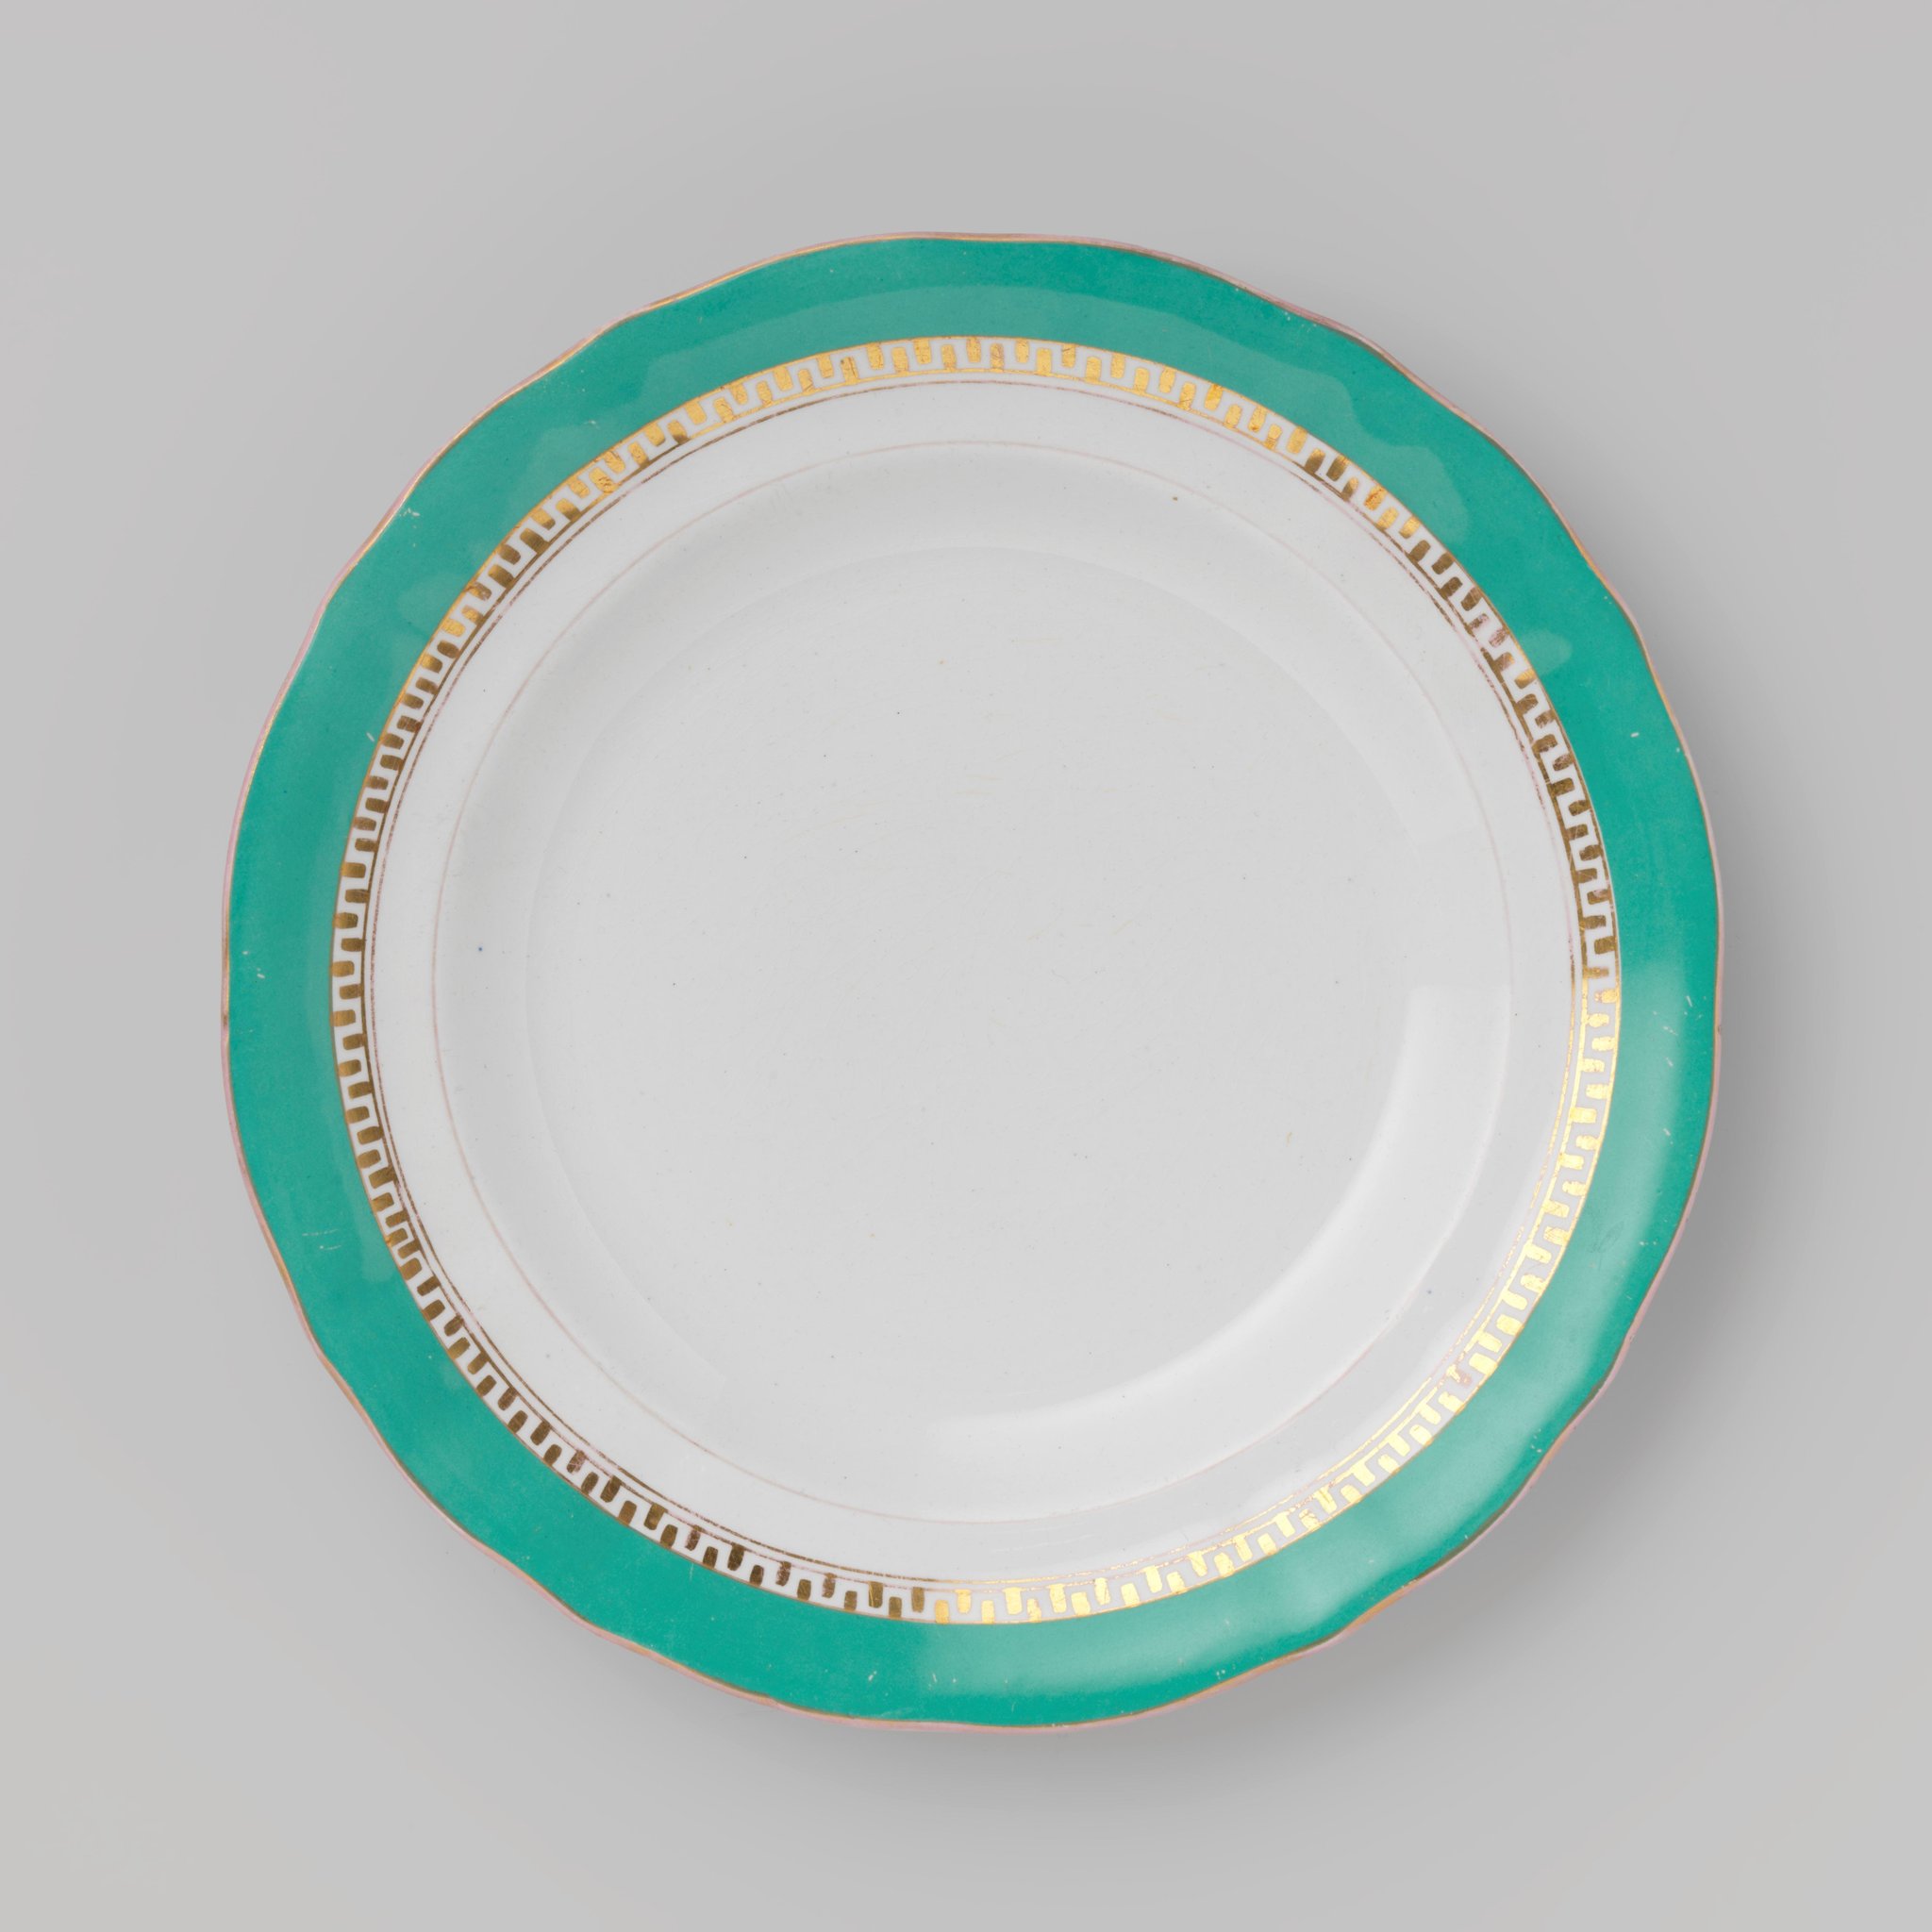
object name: plate dish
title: Bord met groene rand en gouden Griekse band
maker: petrus regout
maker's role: plateelbakker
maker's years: 1801-1879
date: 1865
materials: earthenware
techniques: transfer decoration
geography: maastricht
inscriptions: check stamp: ‘P. REGOUT // MAASTRICHT // 9X’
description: Bord van aardewerk, geschulpt, met groene rand en gouden Griekse band.